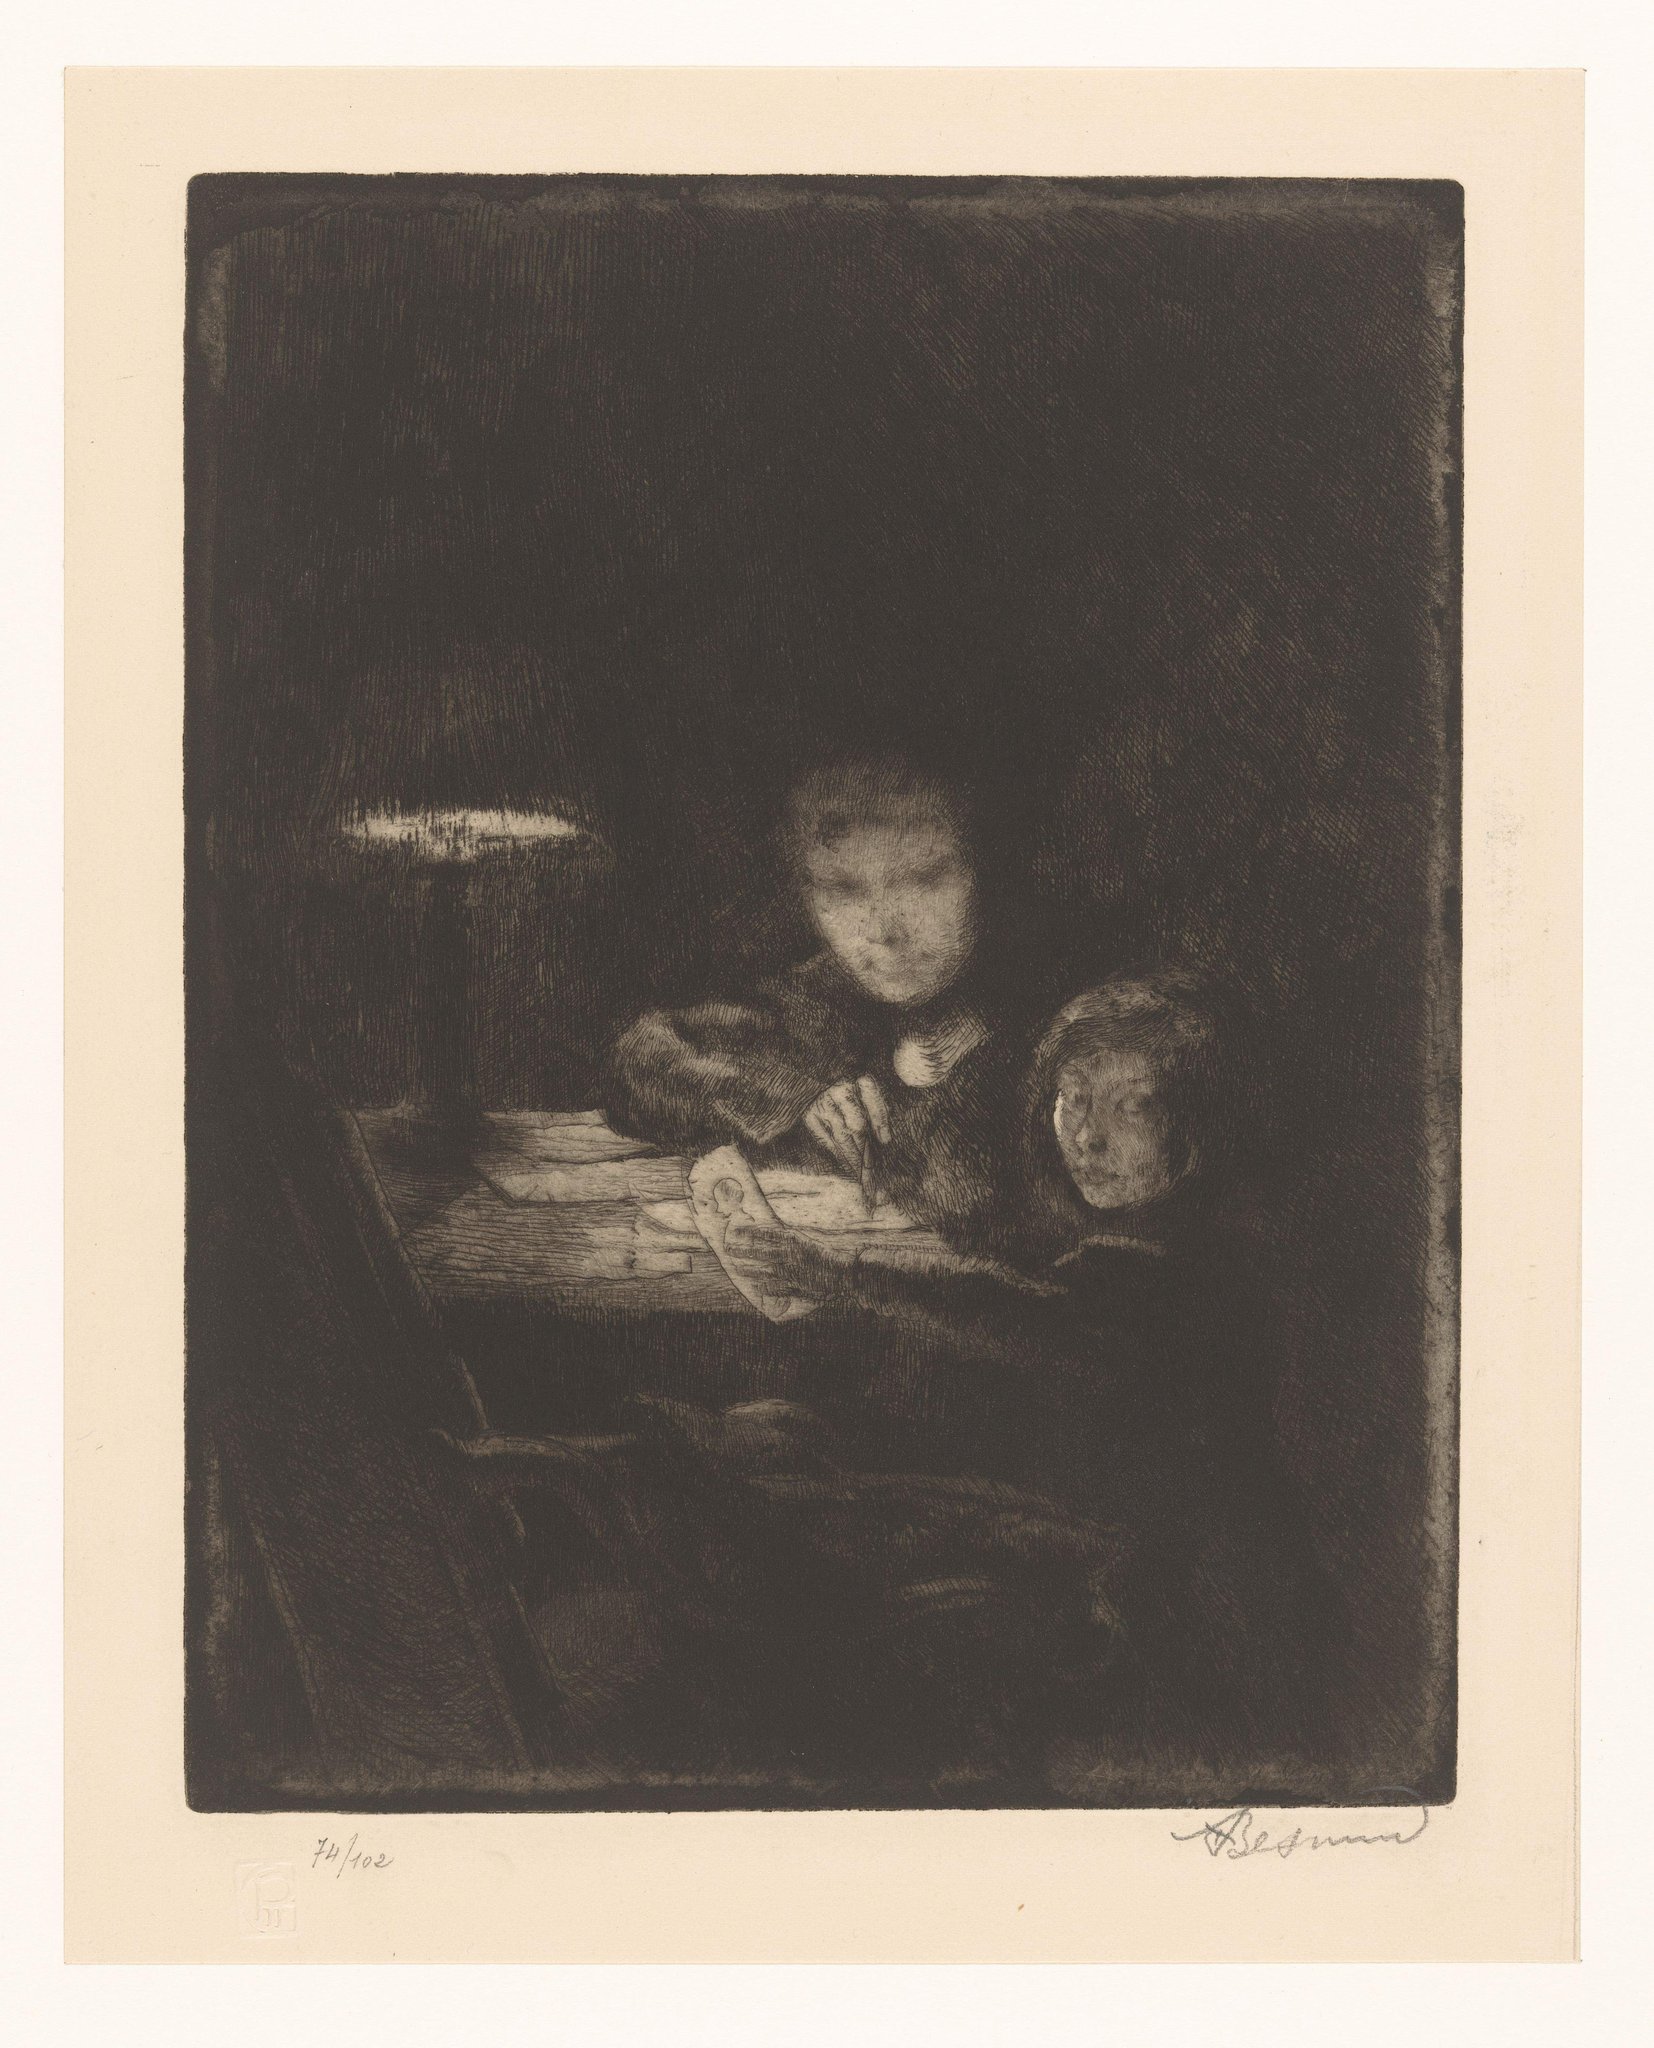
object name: print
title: Tekenende kinderen bij schemerlicht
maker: albert besnard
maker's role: draughtsman, print maker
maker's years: 1849-1934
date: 1859-1929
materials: paper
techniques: drypoint, etching, intaglio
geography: france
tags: child and art, lighting; lamps, darkness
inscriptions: collector's mark: Lugt 2228, collector's mark: Lugt 1195a